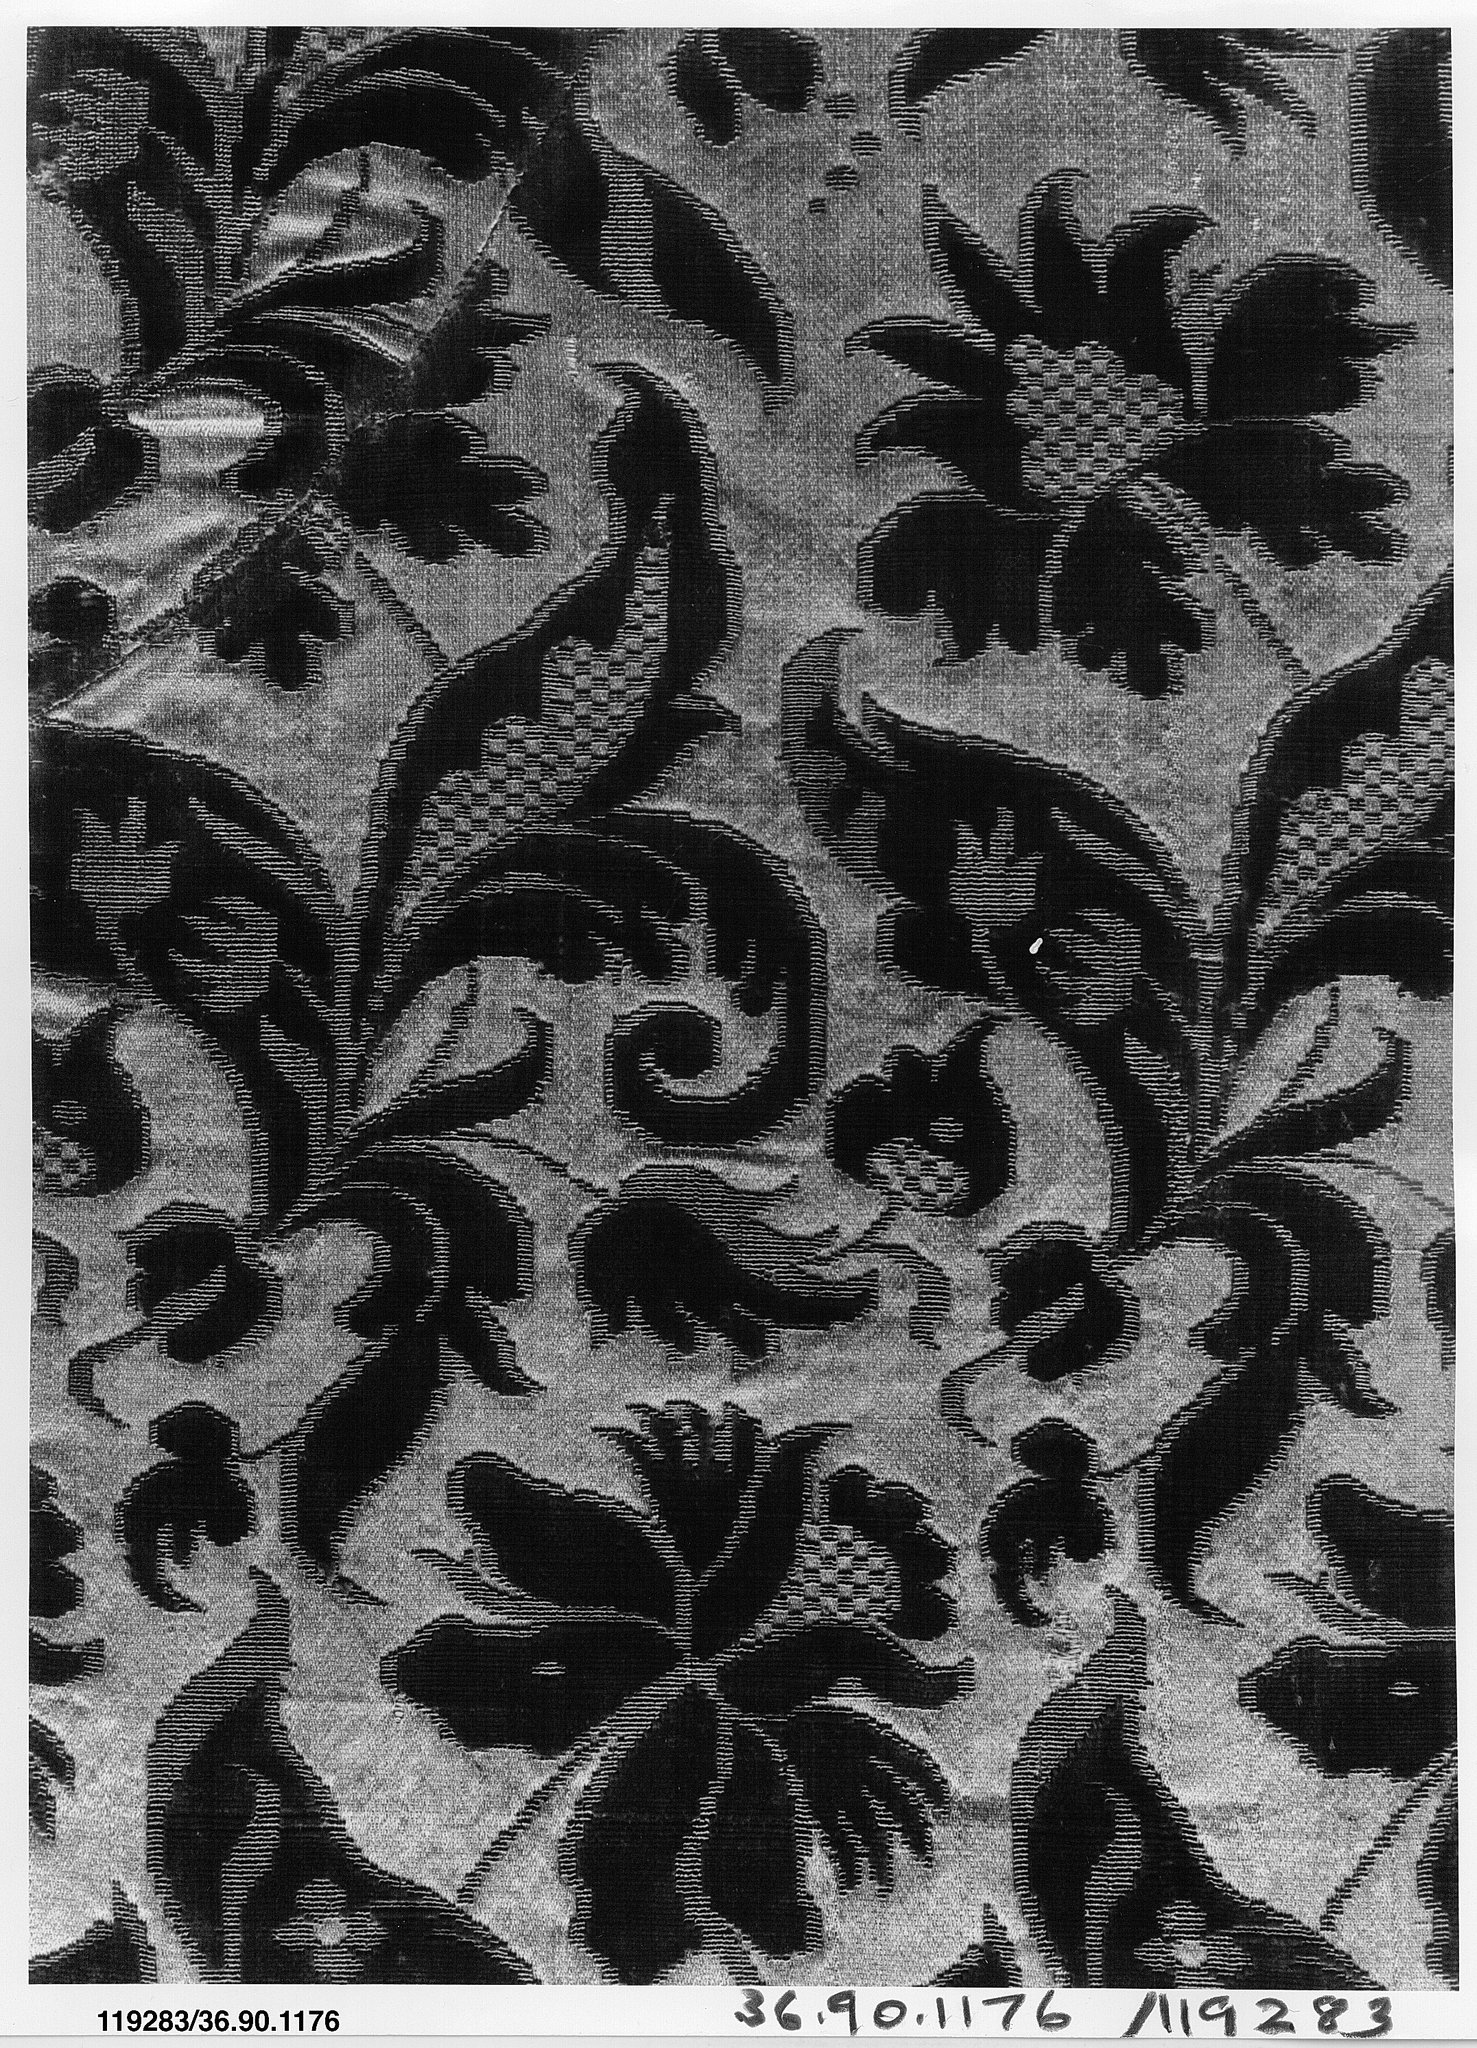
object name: piece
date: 1701-1733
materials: silk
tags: flowers,leaves